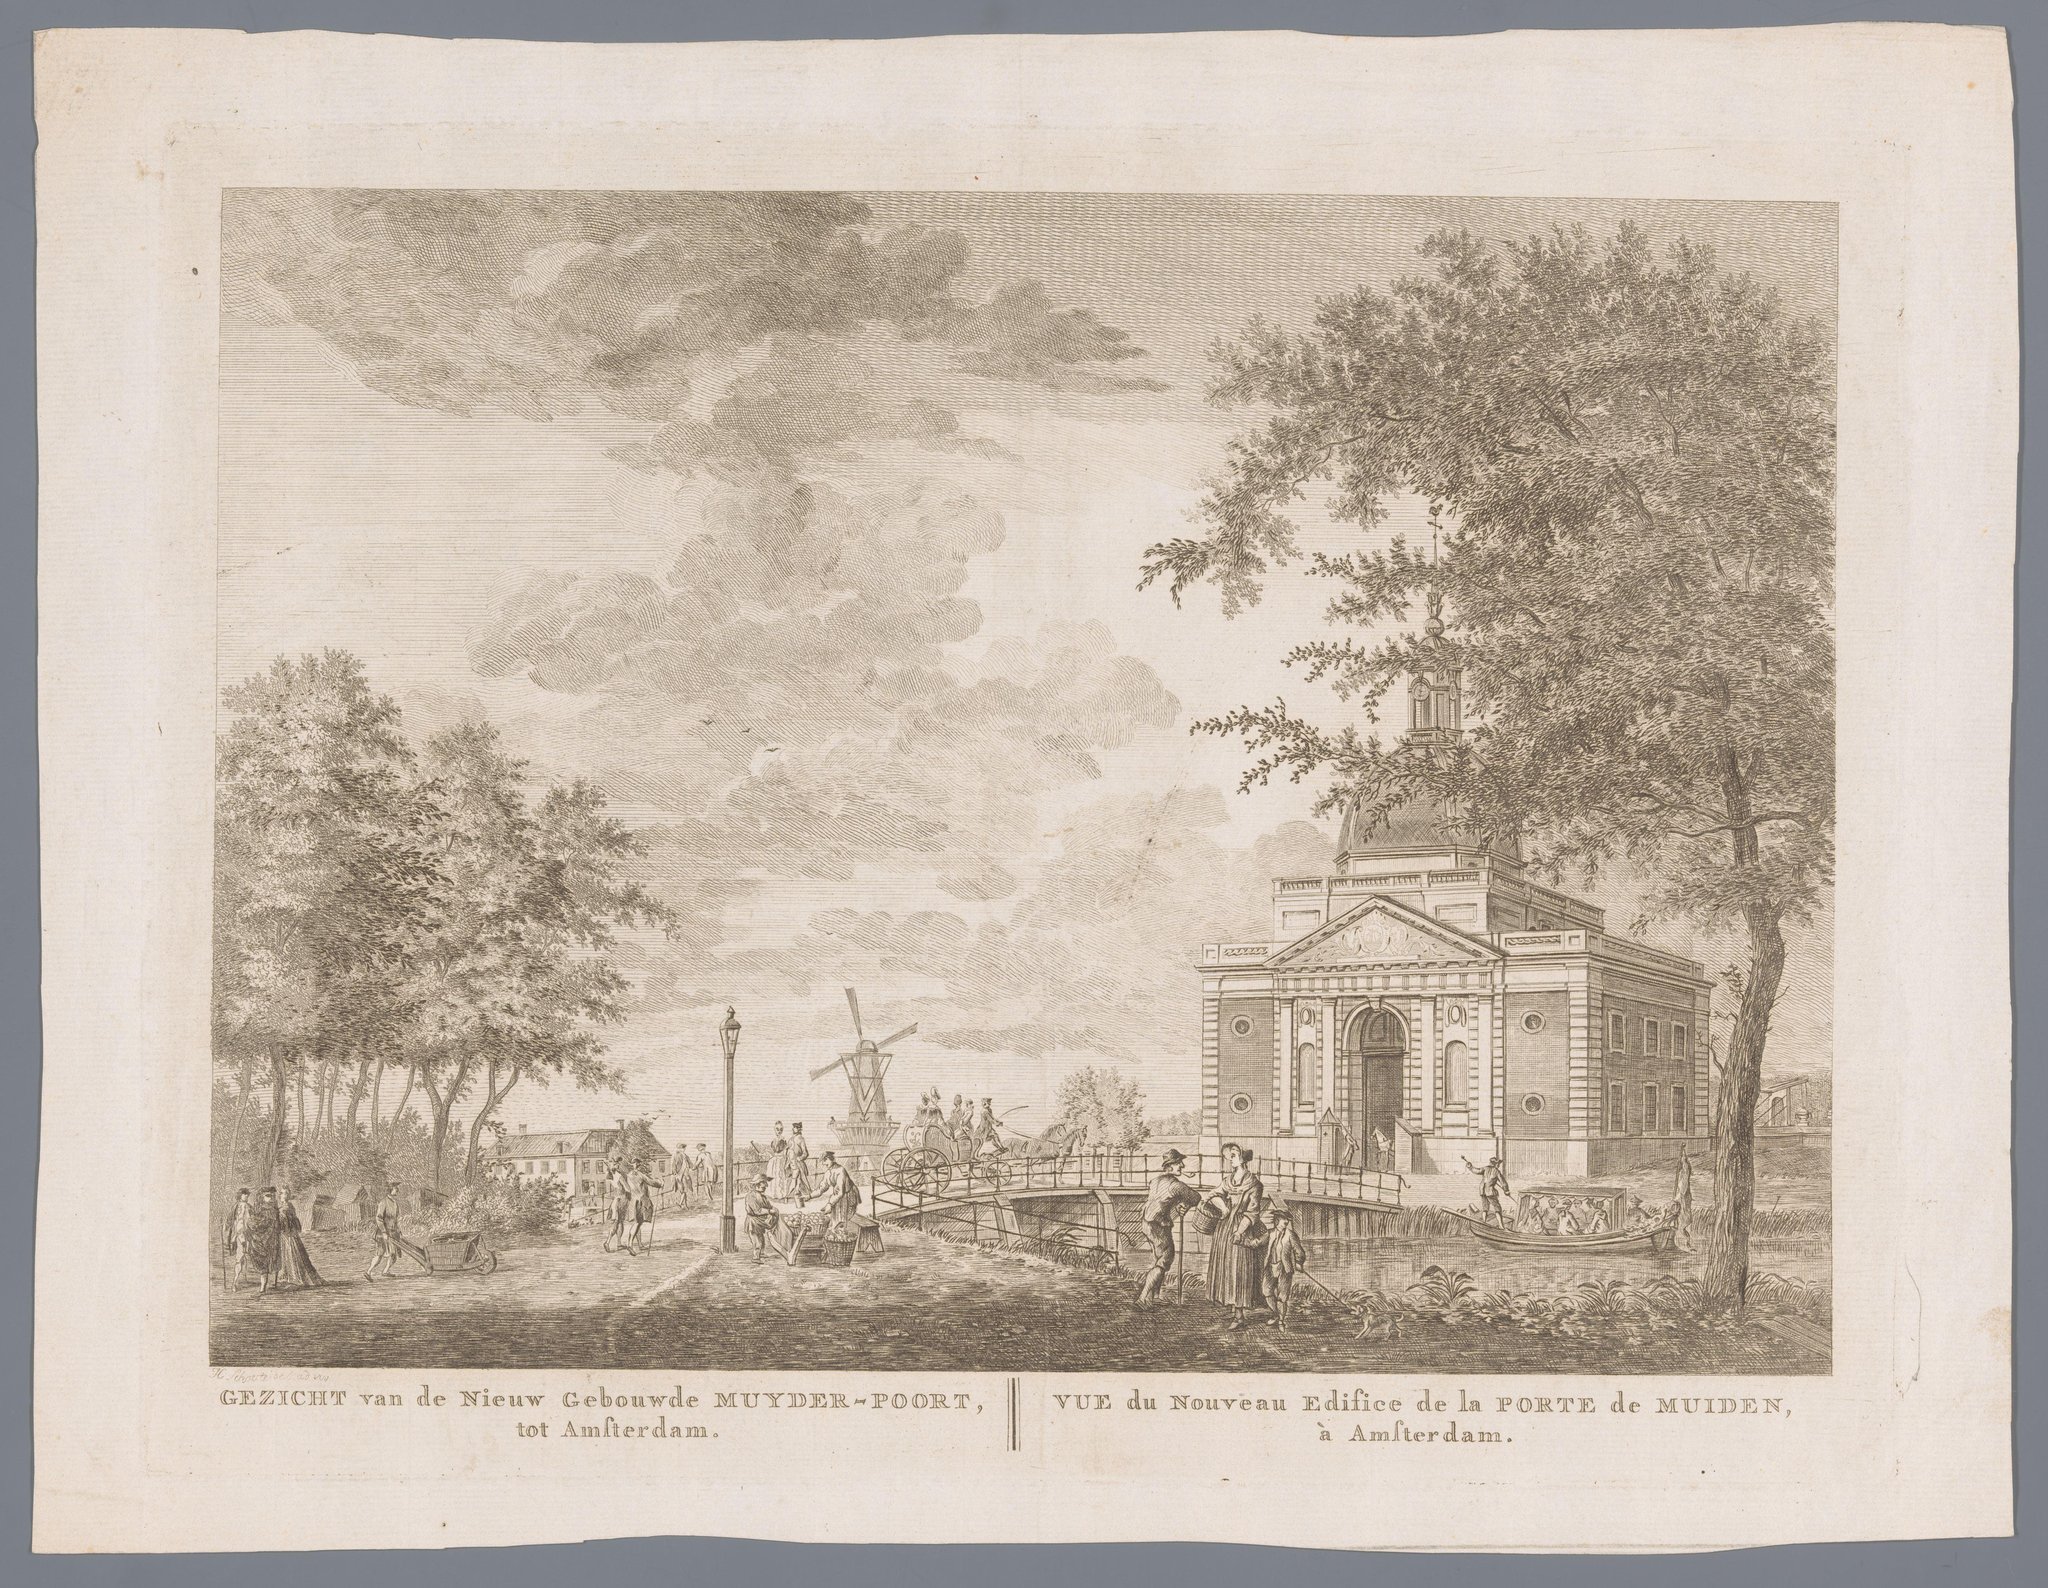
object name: print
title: Gezicht op de Tweede Muiderpoort te Amsterdam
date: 1770-1783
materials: paper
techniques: etching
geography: amsterdam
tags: bridge in city across river, canal, etc. (+ city(-scape) with figures, staffage), windmill, city-gate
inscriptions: collector's mark: Lugt 2228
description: Vanaf 1760 gaf Pierre Fouquet stadsgezichten van Amsterdam naar tekeningen van verschillende kunstenaars uit. Deze prenten werden aanvankelijk los verkocht. Later werden ze samengebonden verkocht in verschillende volgordes en aantallen in: (1). Afbeeldingen van de wyd-vermaarde koopstad Amsterdam benevens des zelvs voornaamste gebouwen en gezigten alle naar het leeven getekend / Receuil des edifices les plus considerables et des plus belles vues, de la fameuse ville d'Amsterdam, dessinées d'après nature. Amsterdam: Pierre Fouquet, 1778-1783. Deze 'uitgave' bestond waarschijnlijk alleen uit een titelblad en inhoudsopgave van de tot dusver 100 uitgegeven prenten, die de koper zelf aan zijn of haar reeds verzamelde prenten kon toevoegen. De hoeveelheid en volgorde van prenten verzameld onder deze titel verschilt dus sterk. (2). Nieuwe atlas, van de voornaamste gebouwen en gezigten der stad Amsterdam, met derzelver beknopte beschryvingen. 2 dln. Amsterdam: Daniël Jean Changuion en Petrus den Hengst [in opdracht van Pierre Fouquet], 1783. Ook werden er door verschillende uitgevers tussen 1788 (Amsterdam: Petrus Conradi) en 1805 (Amsterdam: Evert Maaskamp) heruitgaven gepubliceerd.